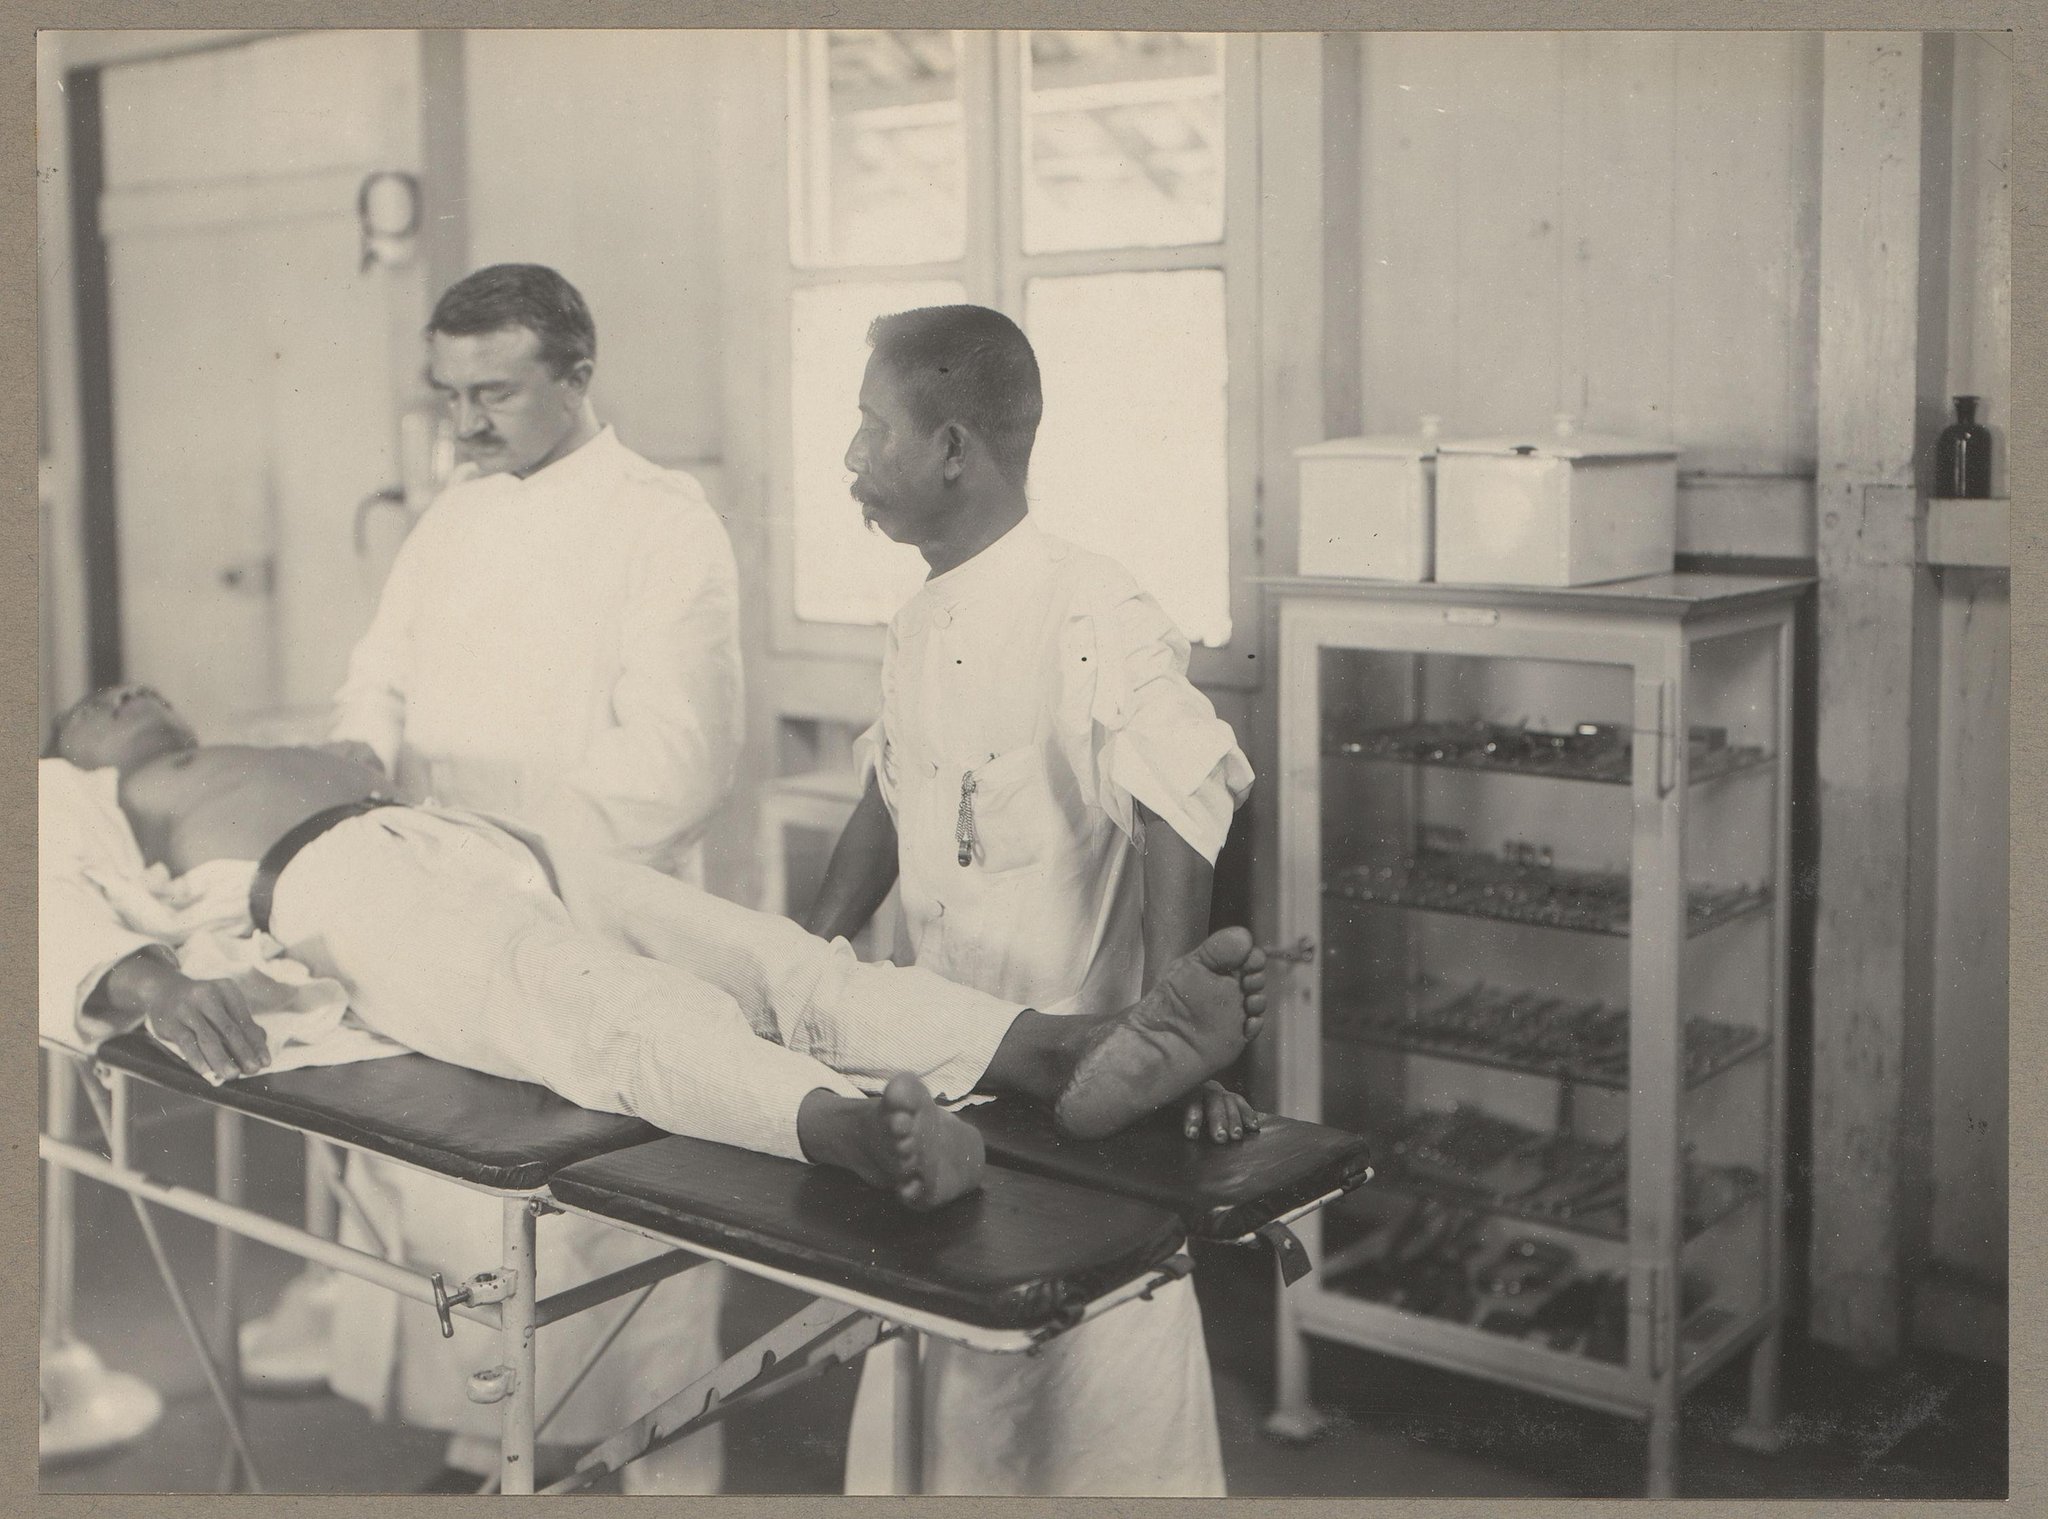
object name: photograph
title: Pangkalpinang. Hospitaal Operatiekamer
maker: Anonymous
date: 1914-1919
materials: photographic support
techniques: gelatin silver print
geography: bangka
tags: robert julius boers, colonial system, mining, operating room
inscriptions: inscription: ‘Pangkalpinang. Hospitaal Operatiekamer’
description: Arts en assistent bij een patiënt op de operatietafel in de operatiekamer in het hospitaal van de Banka-tinwinning te Pangkalpinang. Onderdeel van het fotoalbum aangeboden aan Robert Julius Boers bij zijn vertrek naar Nederland in 1919 door het personeel van de Banka-tinwinning.